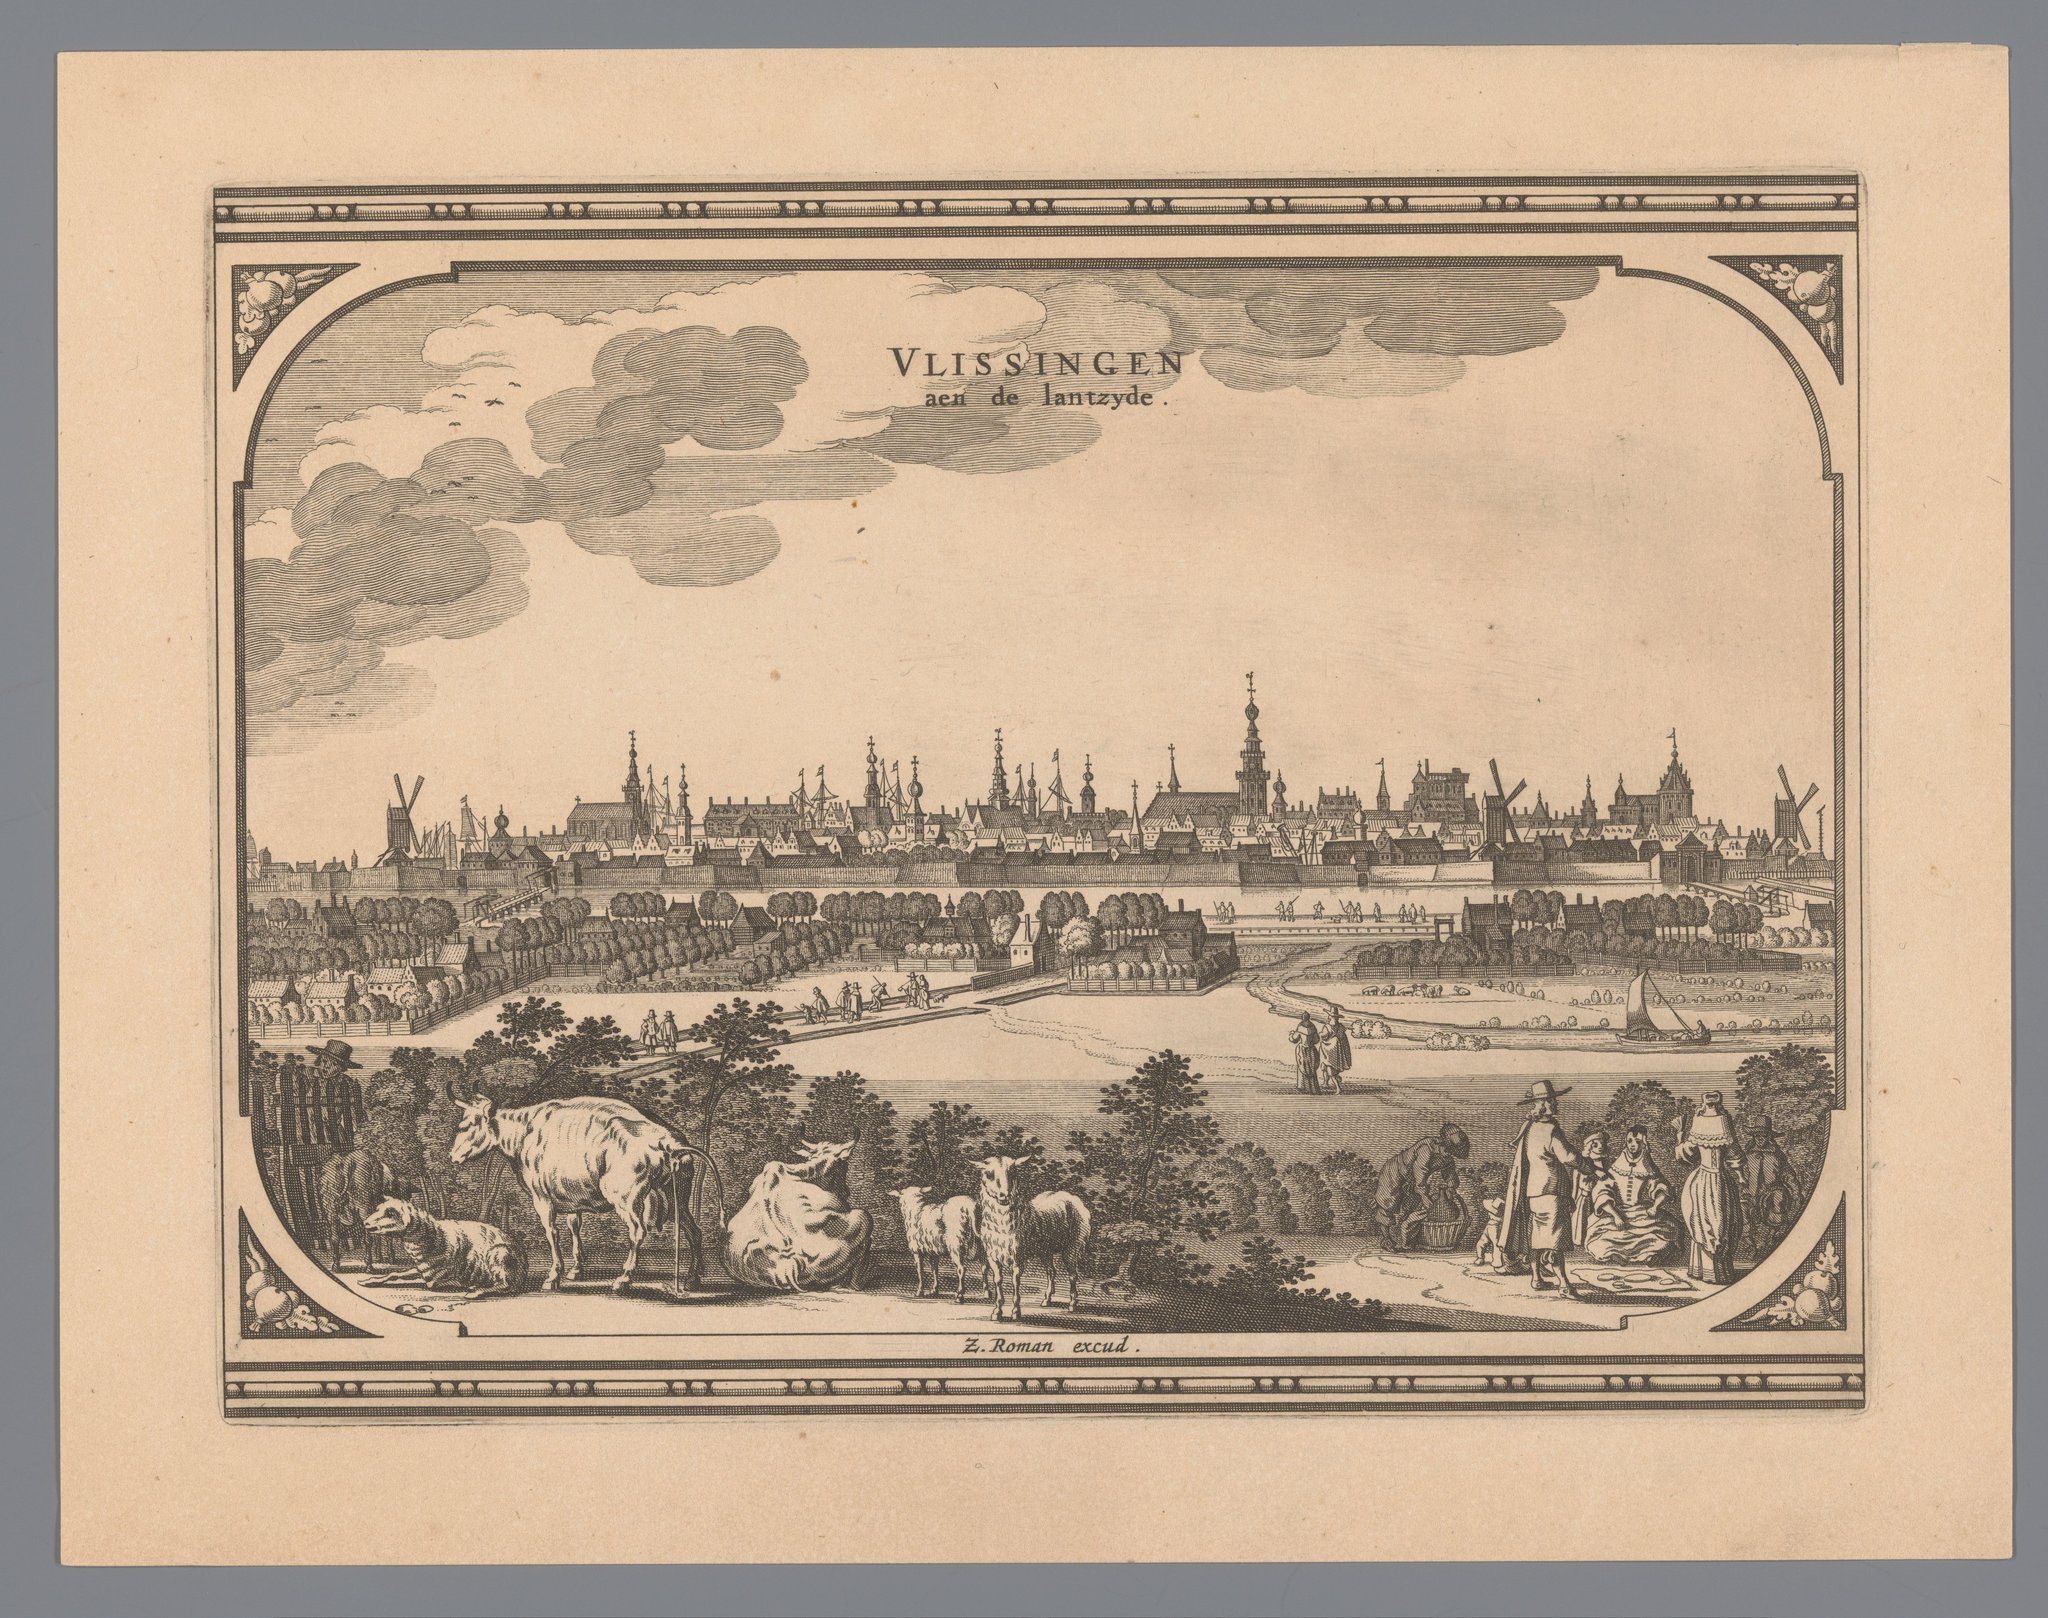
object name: print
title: Stads- en dorpsgezichten in Zeeland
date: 1656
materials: paper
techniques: etching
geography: netherlands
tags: cattle, windmill in landscape, prospect of village, silhouette of village (+ city(-scape) with figures, staffage), flushing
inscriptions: collector's mark: Lugt 2228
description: Prent eerst rond 1656 uitgegeven door Zacharias Roman. Later gebruikt in: Speculum Zelandiae dat is: een beschryvinge ofte afbeelding der steden (...). Amsterdam: Nicolaes Visscher I, 1662 en in een heruitgave van dit werk in 1720 door de weduwe Ottens.